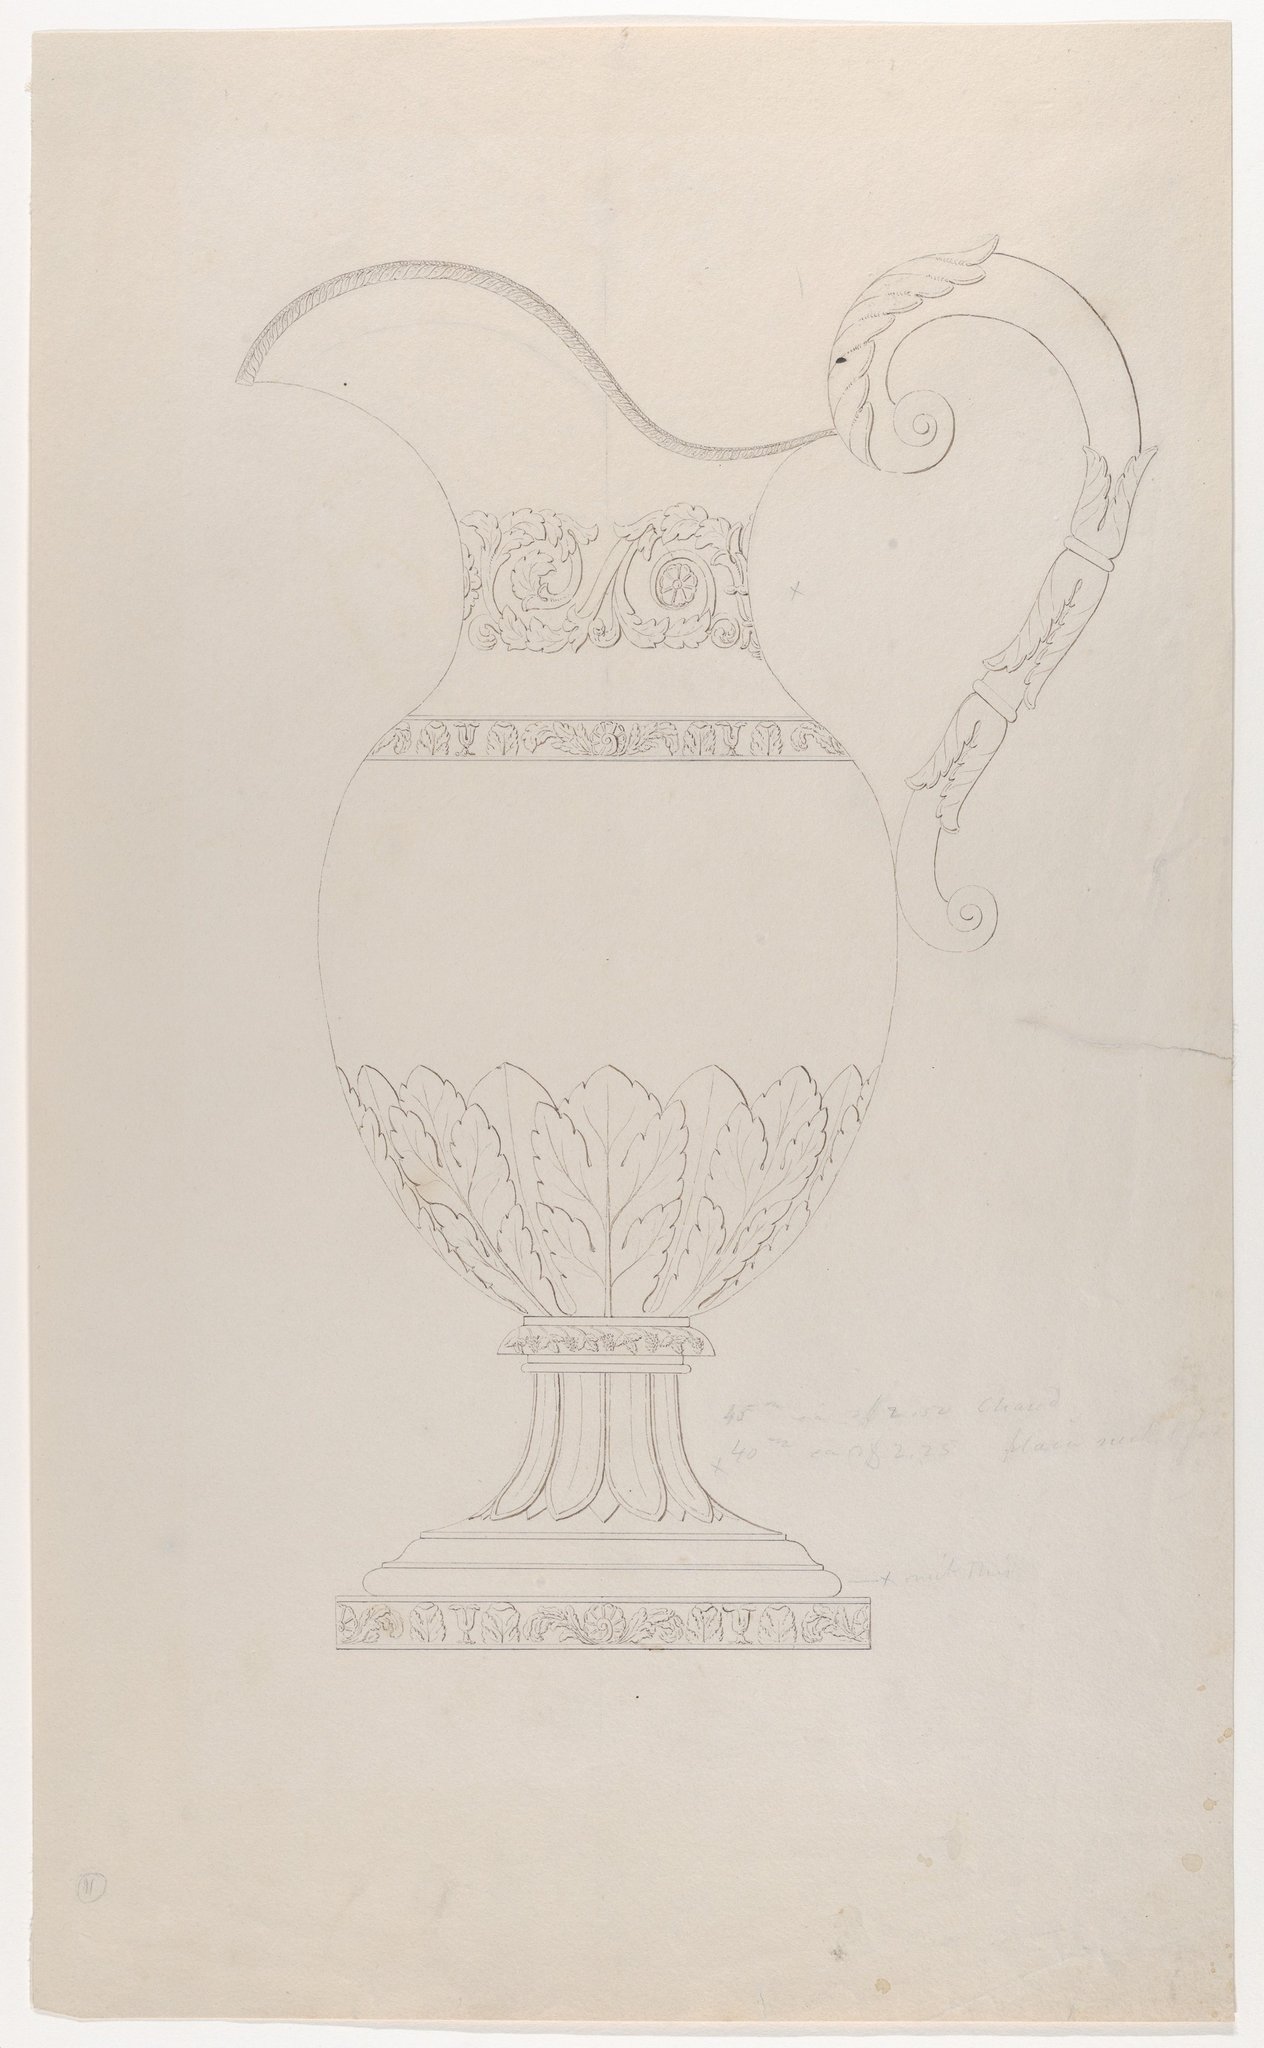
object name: drawing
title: Design for a water pitcher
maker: thomas fletcher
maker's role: artist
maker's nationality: american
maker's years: 1787-1866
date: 1835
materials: graphite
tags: ornament,pitchers